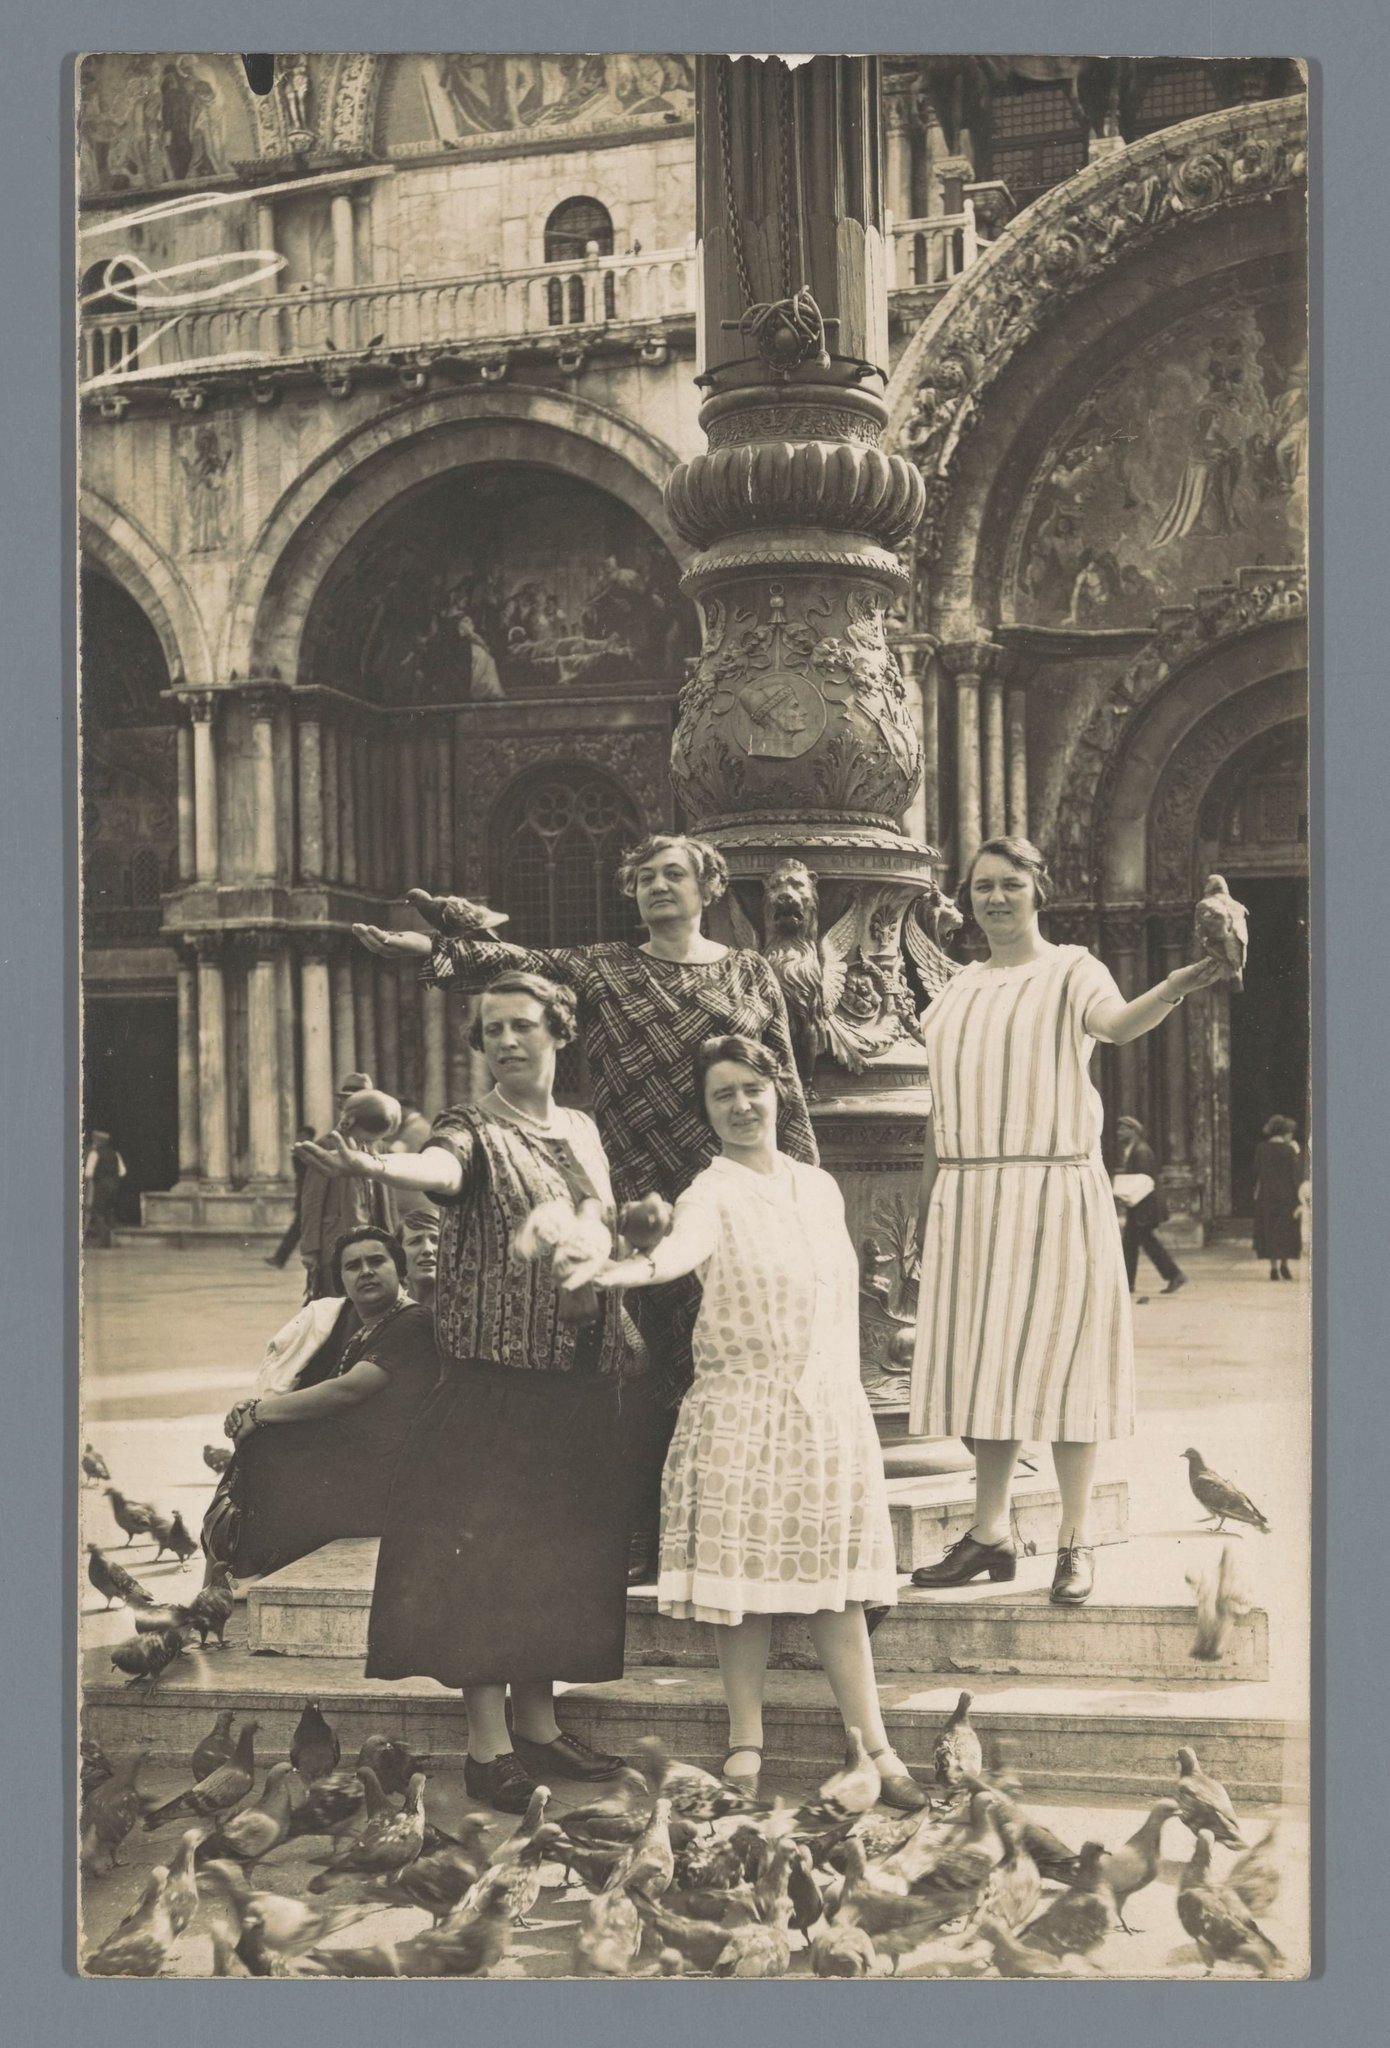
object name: ansichtkaart, prentbriefkaart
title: Vier onbekende vrouwen voeren duiven op het San Marcoplein te Venetië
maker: Anonymous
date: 1925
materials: photographic support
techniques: gelatin silver print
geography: san marco square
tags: adult woman, feeding wild animals, doves, pigeons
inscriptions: inscription: ‘1925’